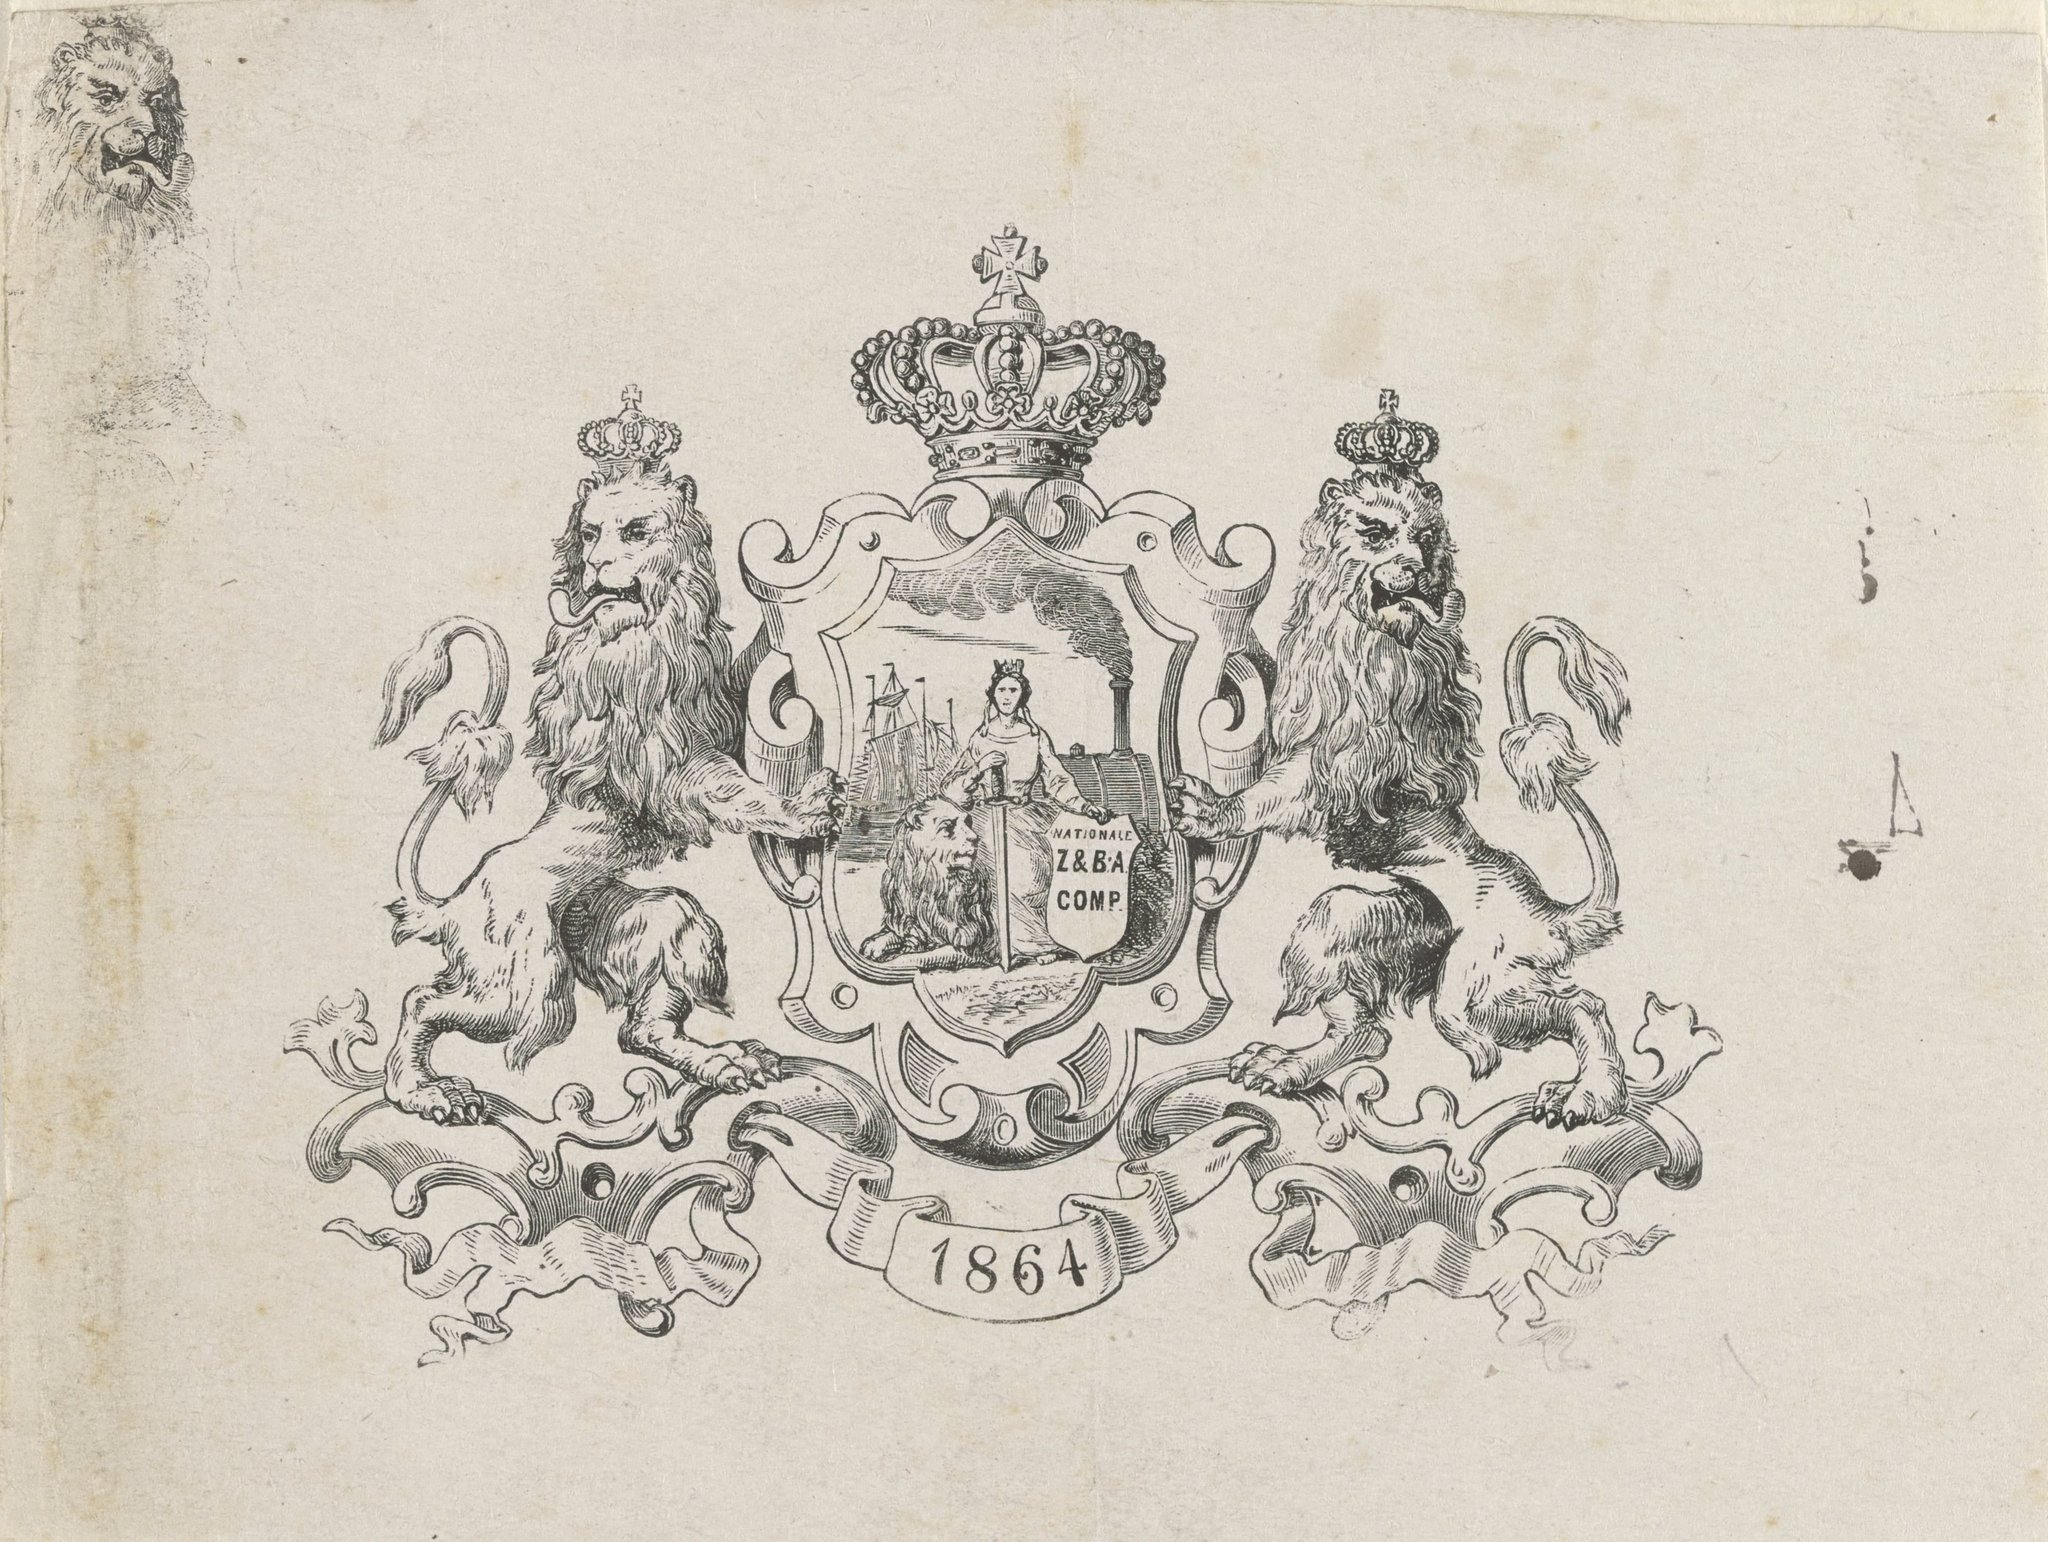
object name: print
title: Nederlandse Maagd en de Nederlandse Leeuw in een geornamenteerde omlijsting met een kroon, twee leeuwen en het jaartal '1864'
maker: isaac weissenbruch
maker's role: print maker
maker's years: 1826-1912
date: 1864-1912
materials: paper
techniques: engraving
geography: netherlands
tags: crown (symbol of sovereignty), personifications of countries, nations, states, districts, etc., symbols of particular nations, states, districts, etc.